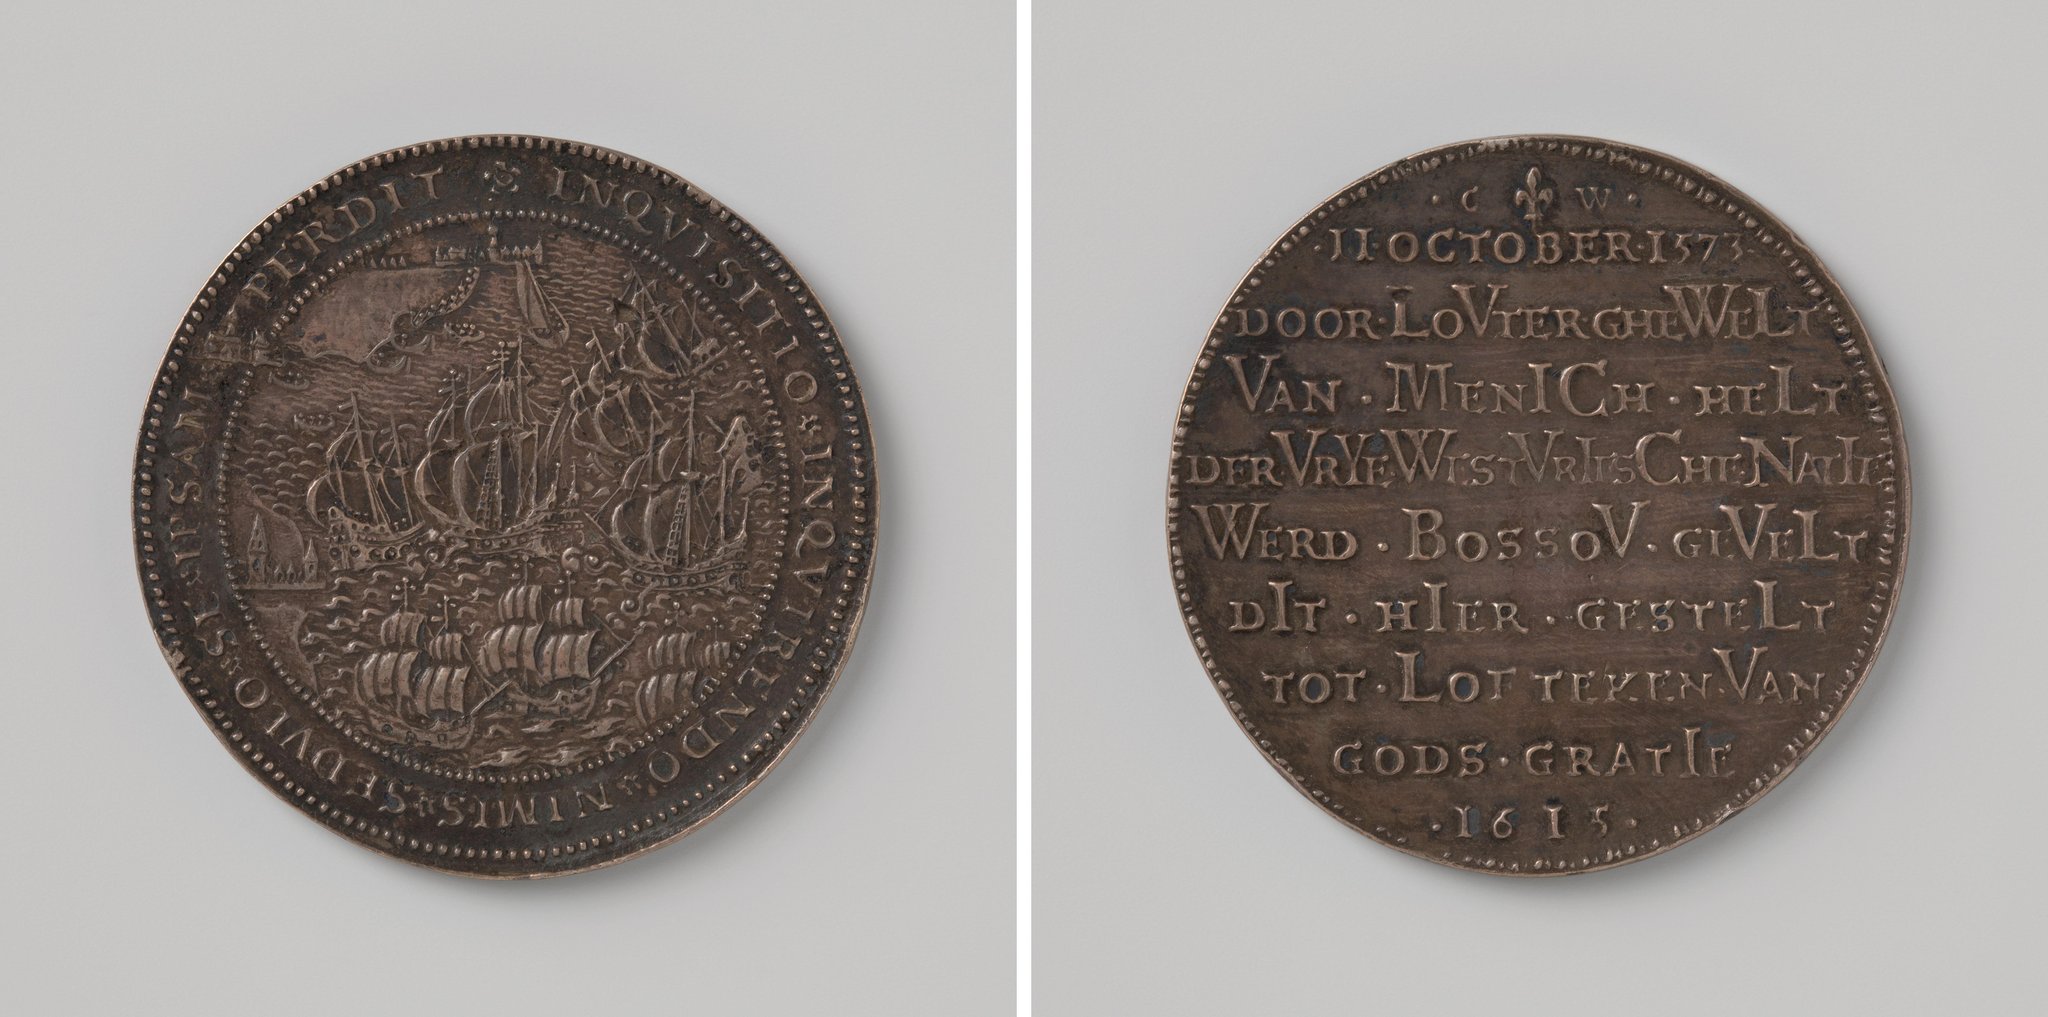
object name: triomfpenning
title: Herdenking van de nederlaag van Bossu op de Zuiderzee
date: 1615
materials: silver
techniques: striking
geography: west frisia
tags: antwerp, earl, zuiderzee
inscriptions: inscription: ‘II OCTOBER 1573/ DOOR LOVTER GHEWELT/ VAN MENICH HELT/ DER VRYE WEST VRIESCHE NATIE/ WERD BOSSOV GEVELT/ DIT HIER GESTELT/ TOT LOFTEKEN VAN/ GODS GRAIE/ 1615’, signature: ‘CW’, circumscription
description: Zilveren penning. Voorzijde: zeeslag binnen omschrift. Keerzijde: opschrift